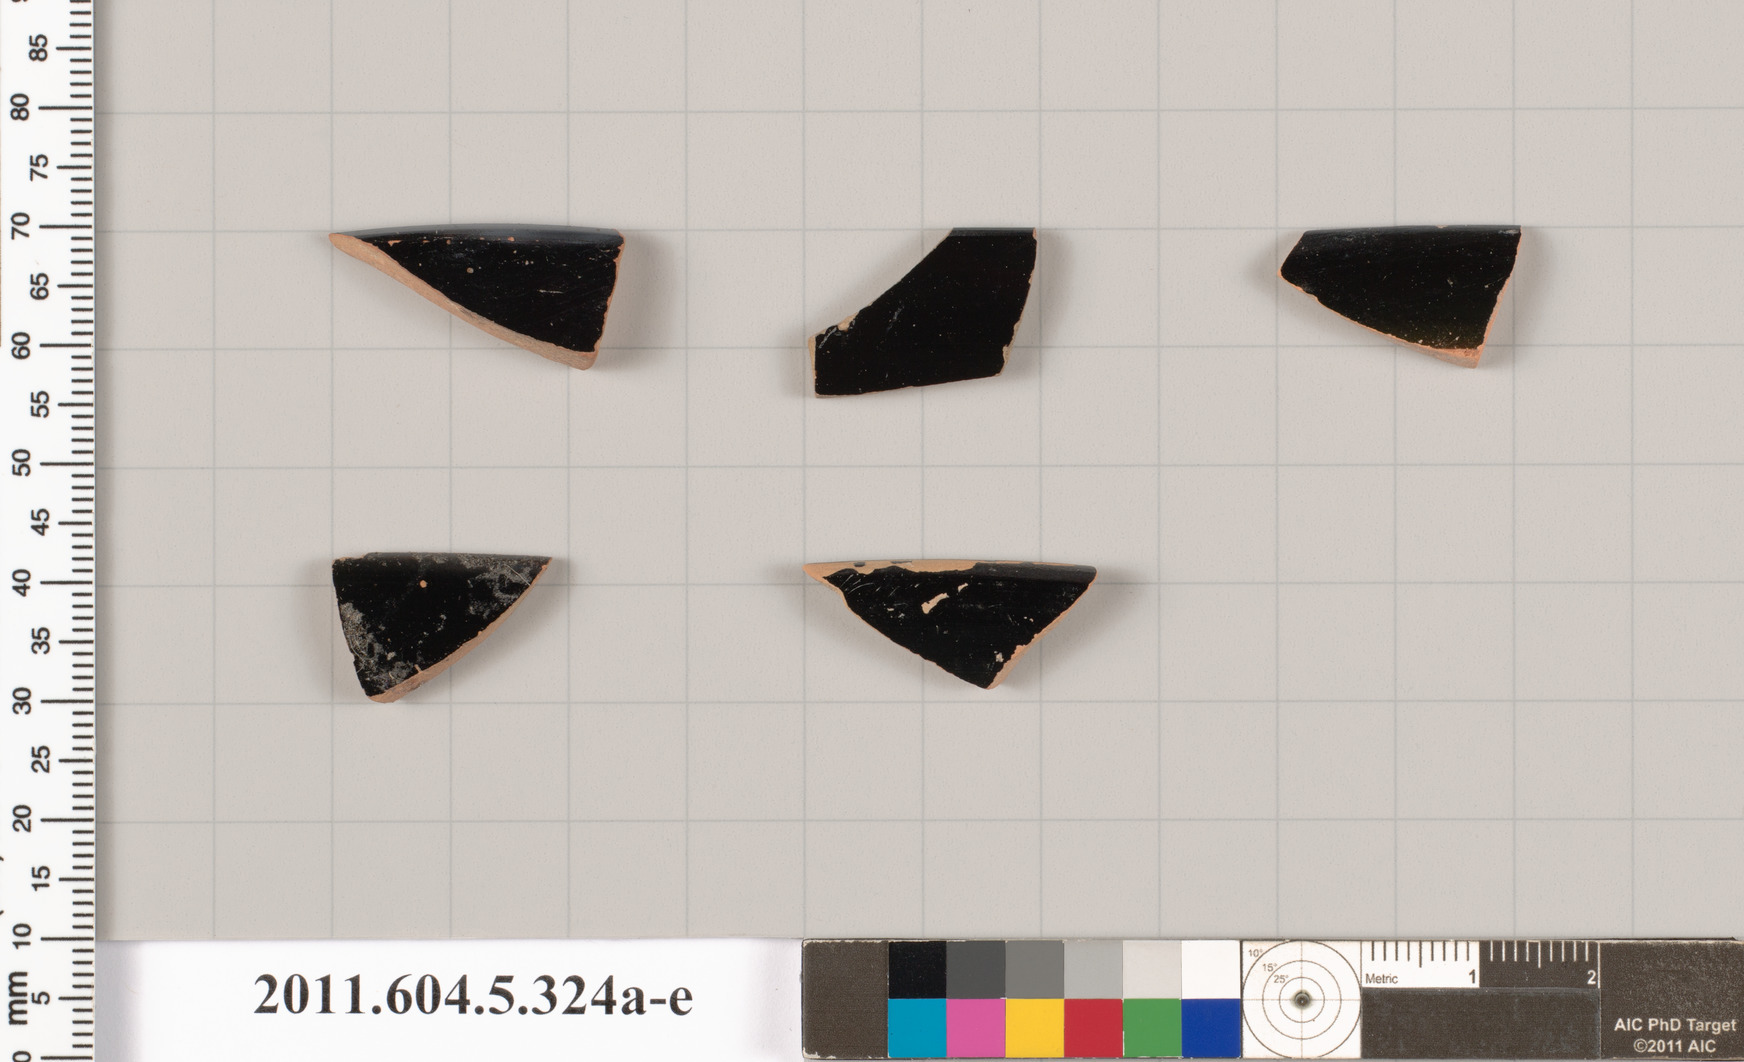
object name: kylix fragment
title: Terracotta rim fragments of kylikes (drinking cups)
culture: greek, attic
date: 600-401 BCE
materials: terracotta